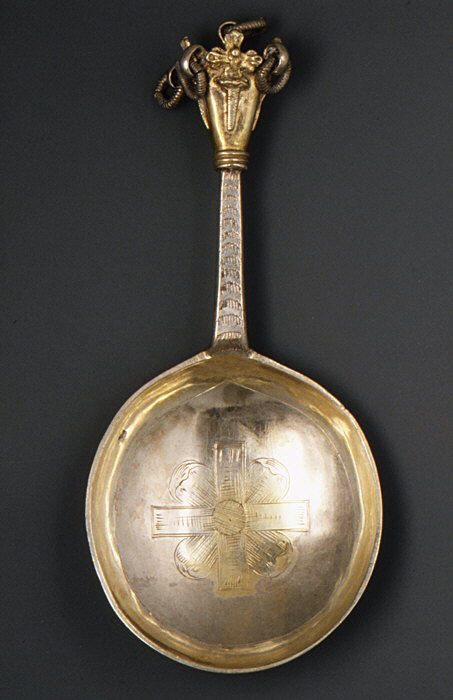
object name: spoon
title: Crown-top spoon (one of three)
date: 1501-1600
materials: gilt, silver